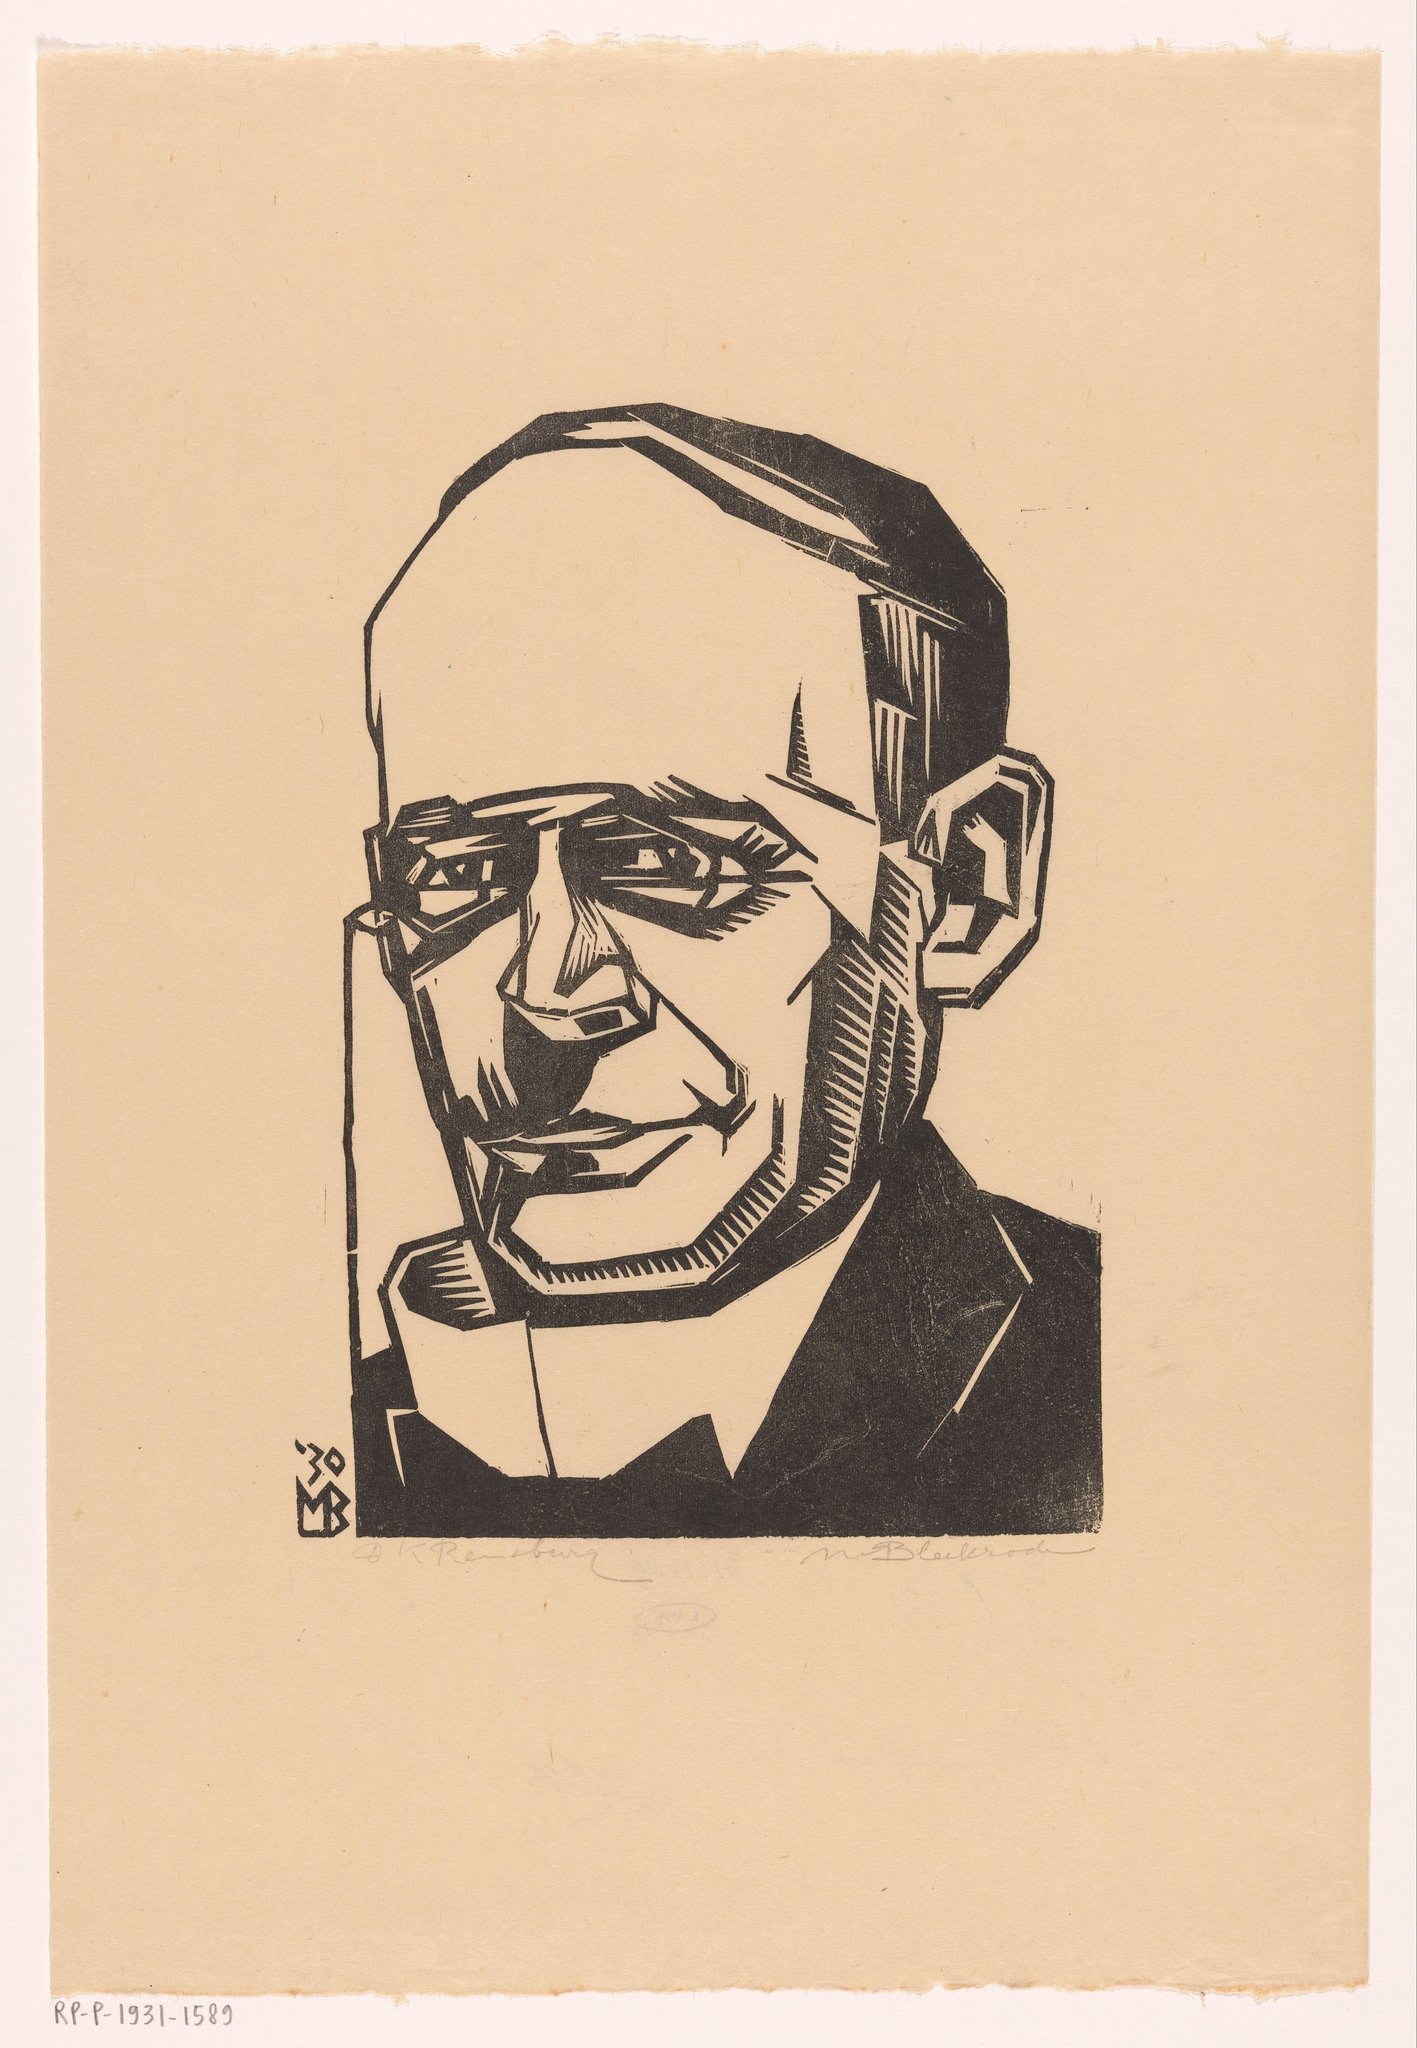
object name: print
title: Portret van Jacques Karel Rensburg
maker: meijer bleekrode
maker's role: draughtsman, painter, print maker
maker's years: 1896-1943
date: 1930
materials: paper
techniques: woodcut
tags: writer, poet, author, historical persons (portraits and scenes from the life)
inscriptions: collector's mark: Lugt 2228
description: Portret van de dichter Jacques Karel Rensburg met bril, van voren gezien.